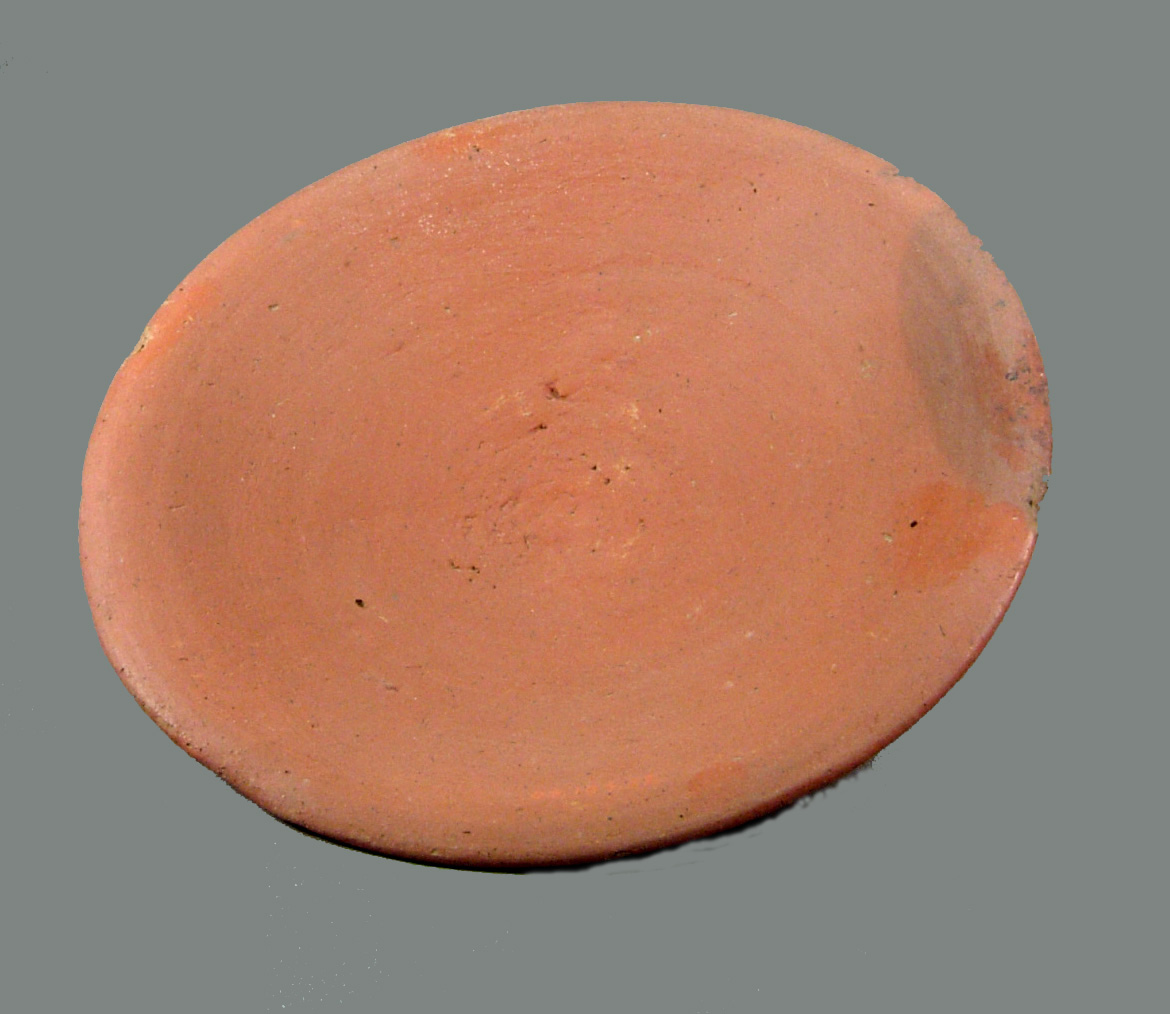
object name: dish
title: Dish from Tutankhamun's Embalming Cache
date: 1336-1327 BCE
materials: mineral, pottery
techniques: wash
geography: egypt